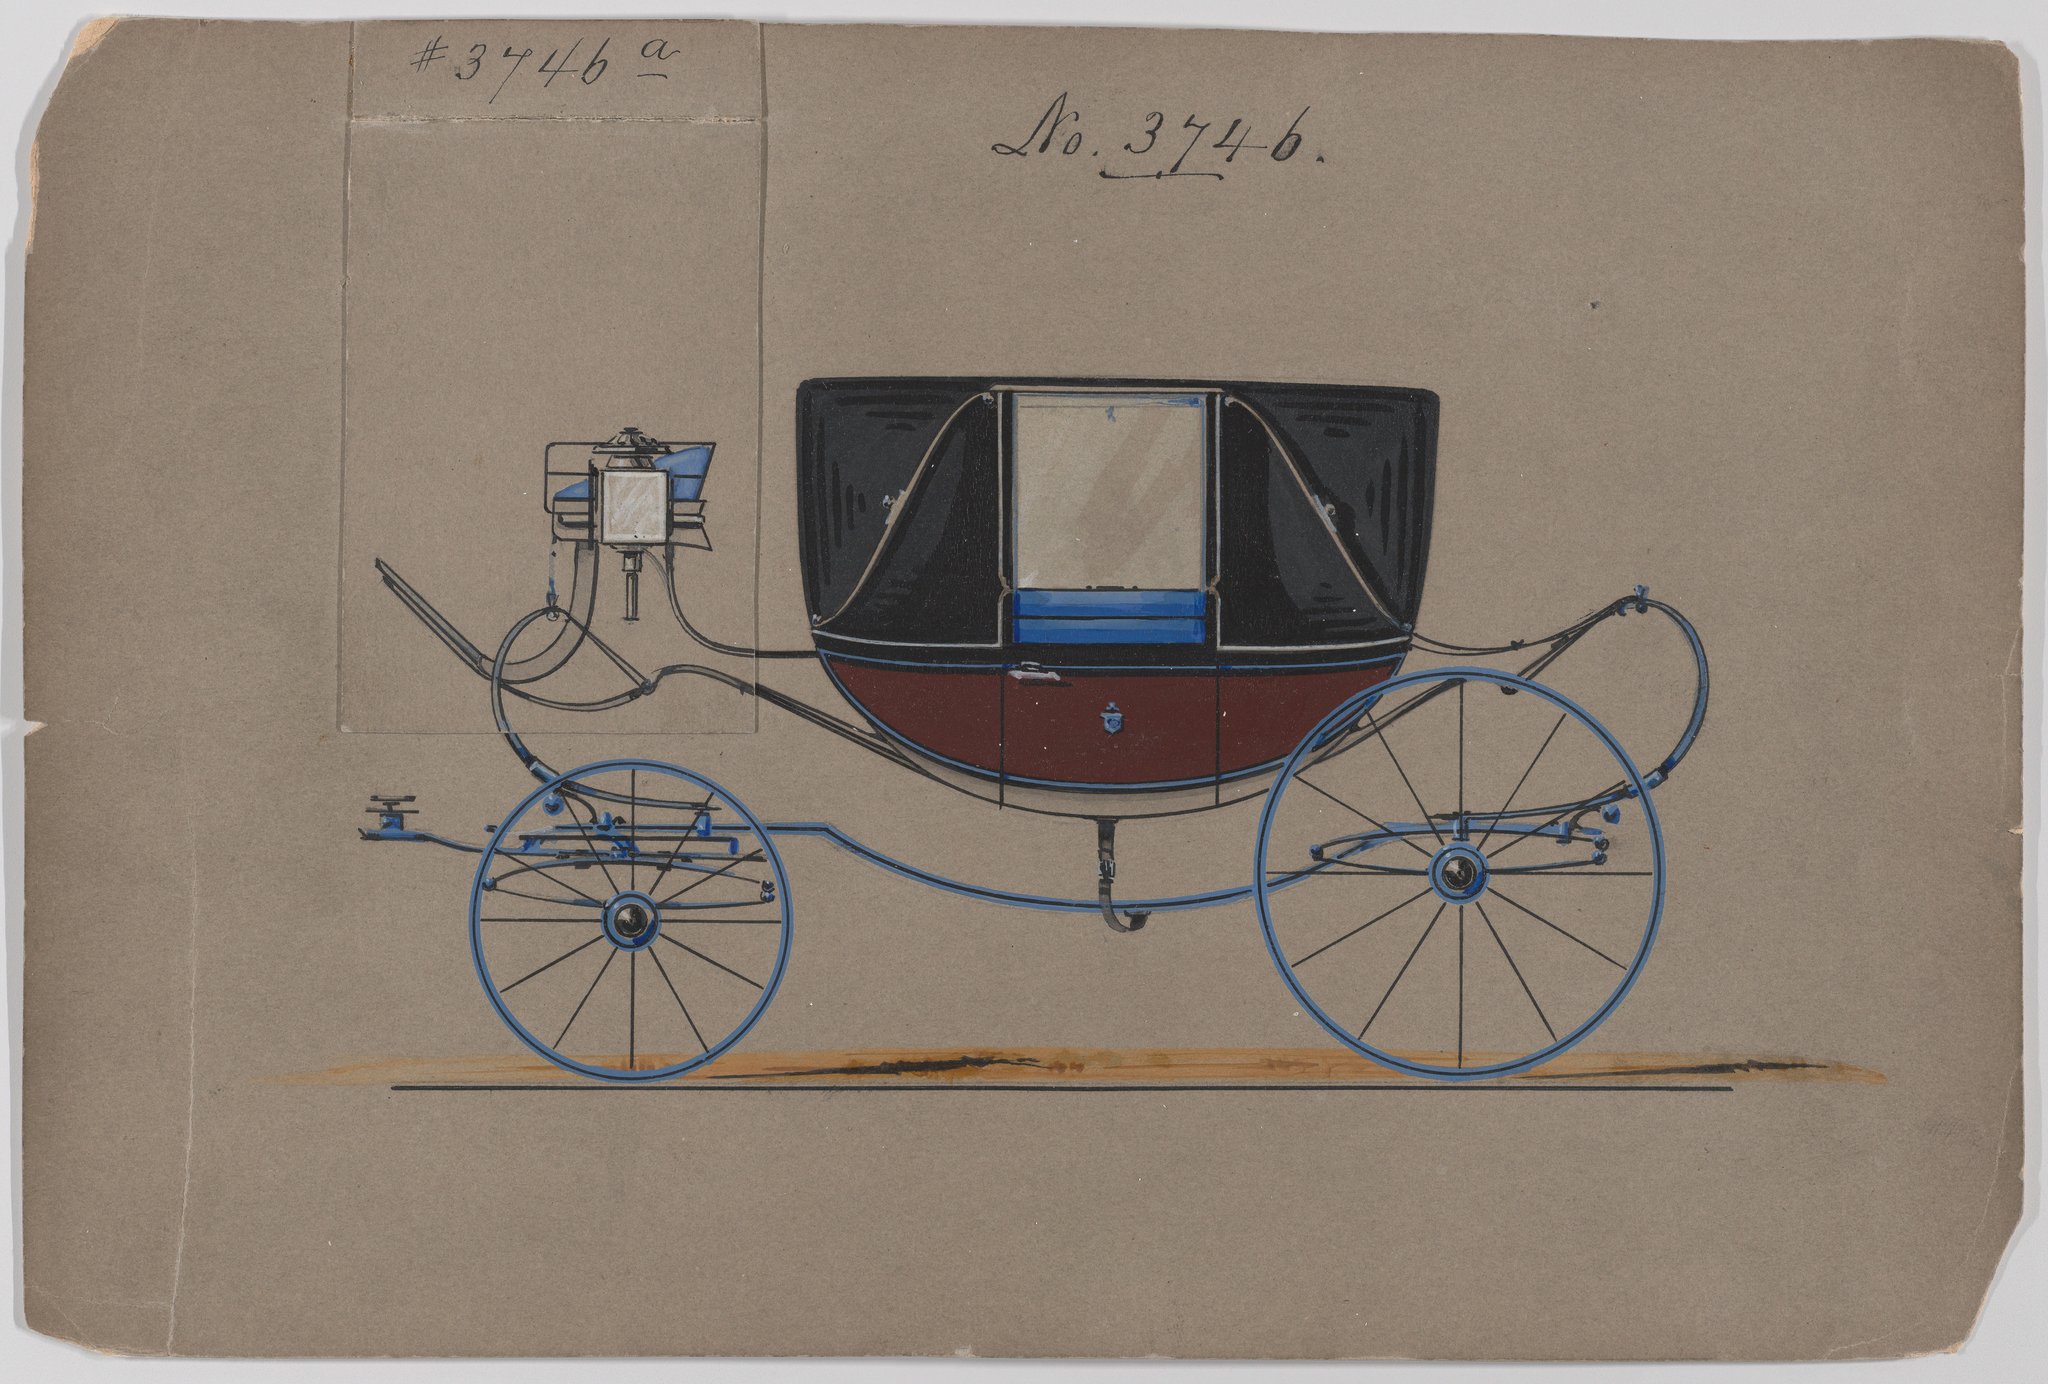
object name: drawing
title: Design for Landau, No. 3746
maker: brewster & co.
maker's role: manufacturer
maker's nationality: american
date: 1882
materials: gouache, gum arabic, ink, watercolor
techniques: pen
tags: carriages